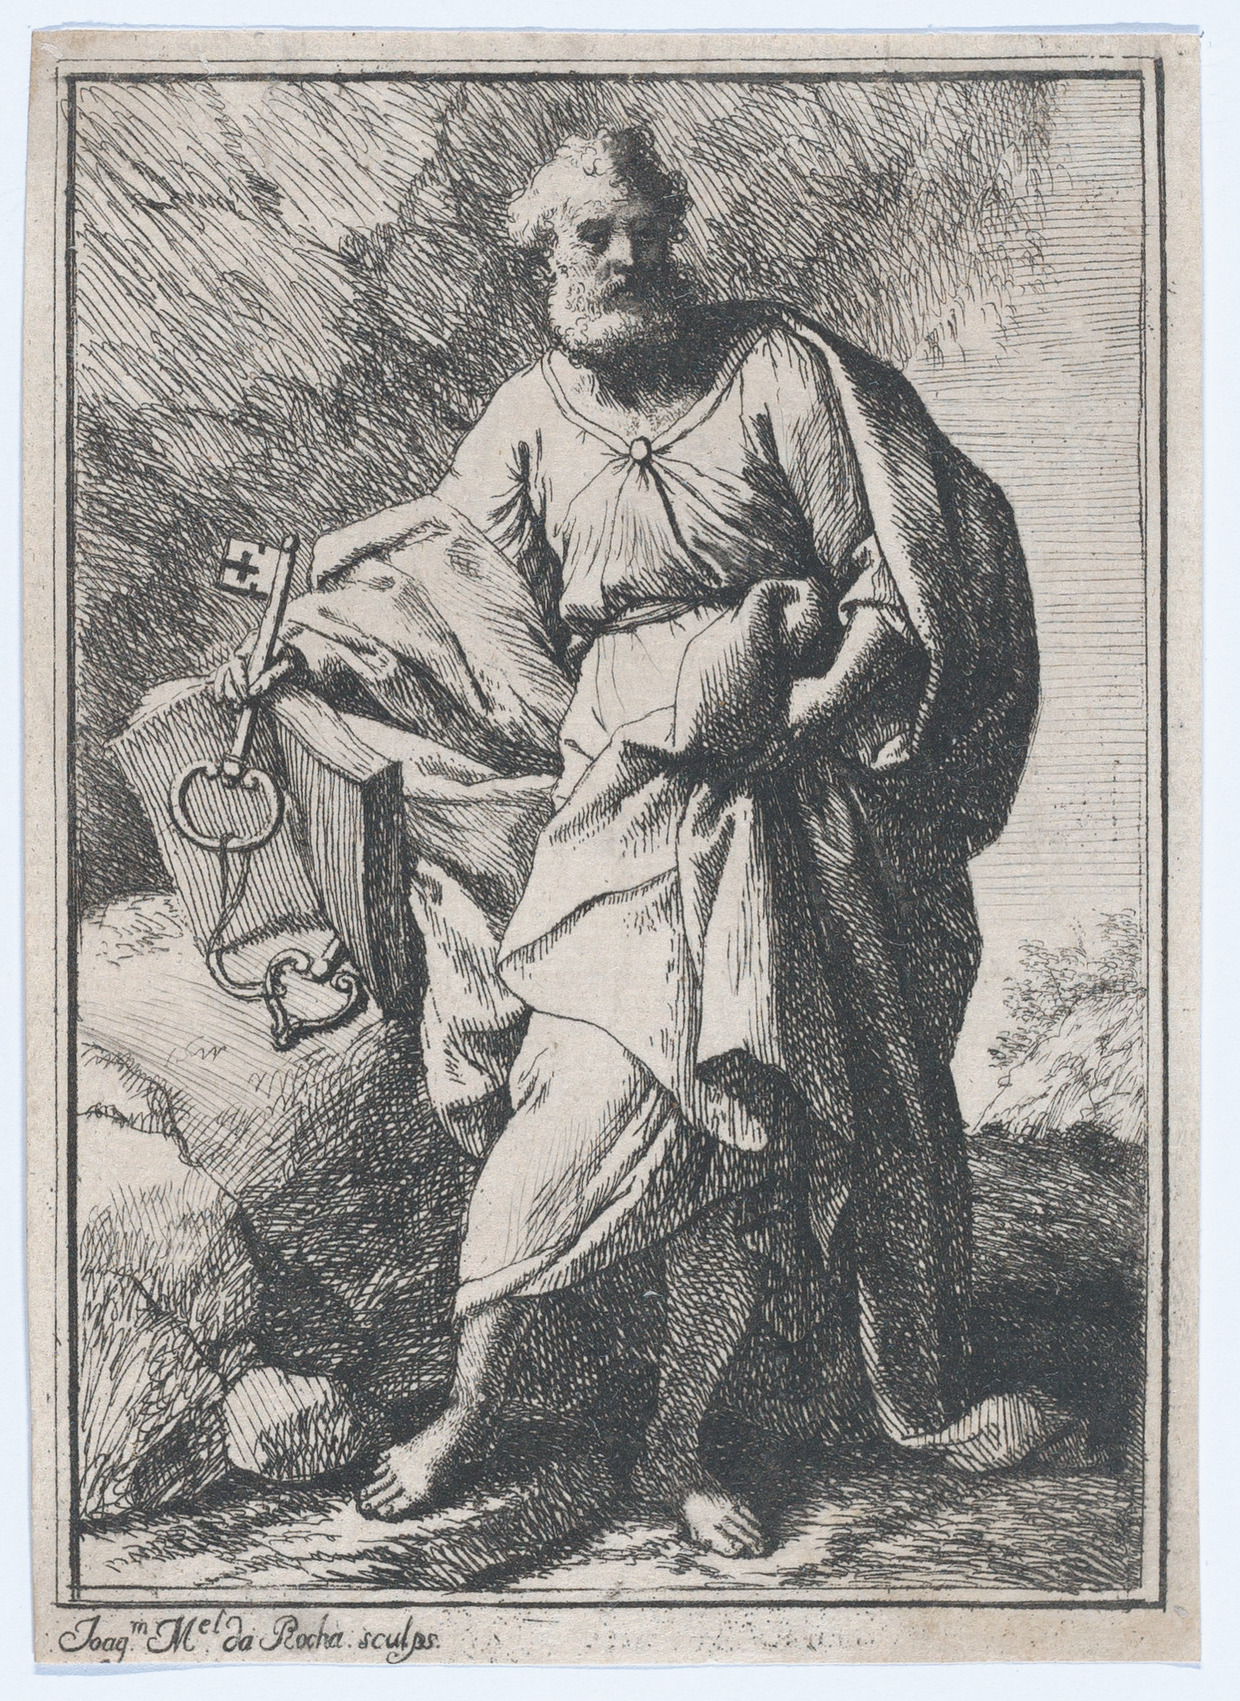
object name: print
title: Saint Peter holding keys and an open book, facing left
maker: joachim leonardo da rocha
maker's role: artist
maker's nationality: portuguese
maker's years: 1756-1826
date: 1750-1780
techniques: etching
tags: books,saint peter,keys